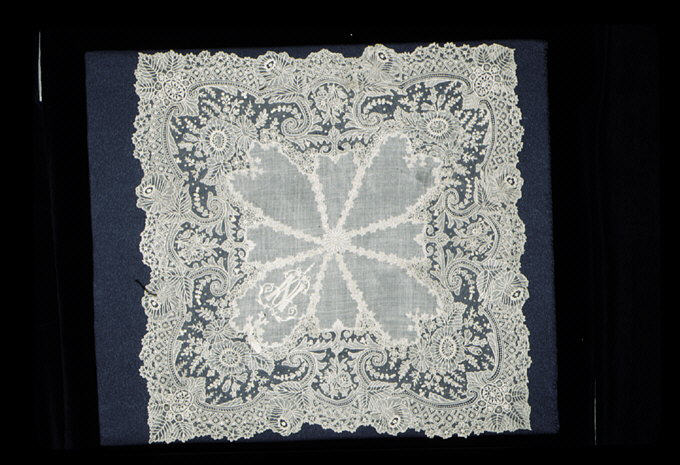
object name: handkerchief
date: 1801-1900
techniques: lace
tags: flowers